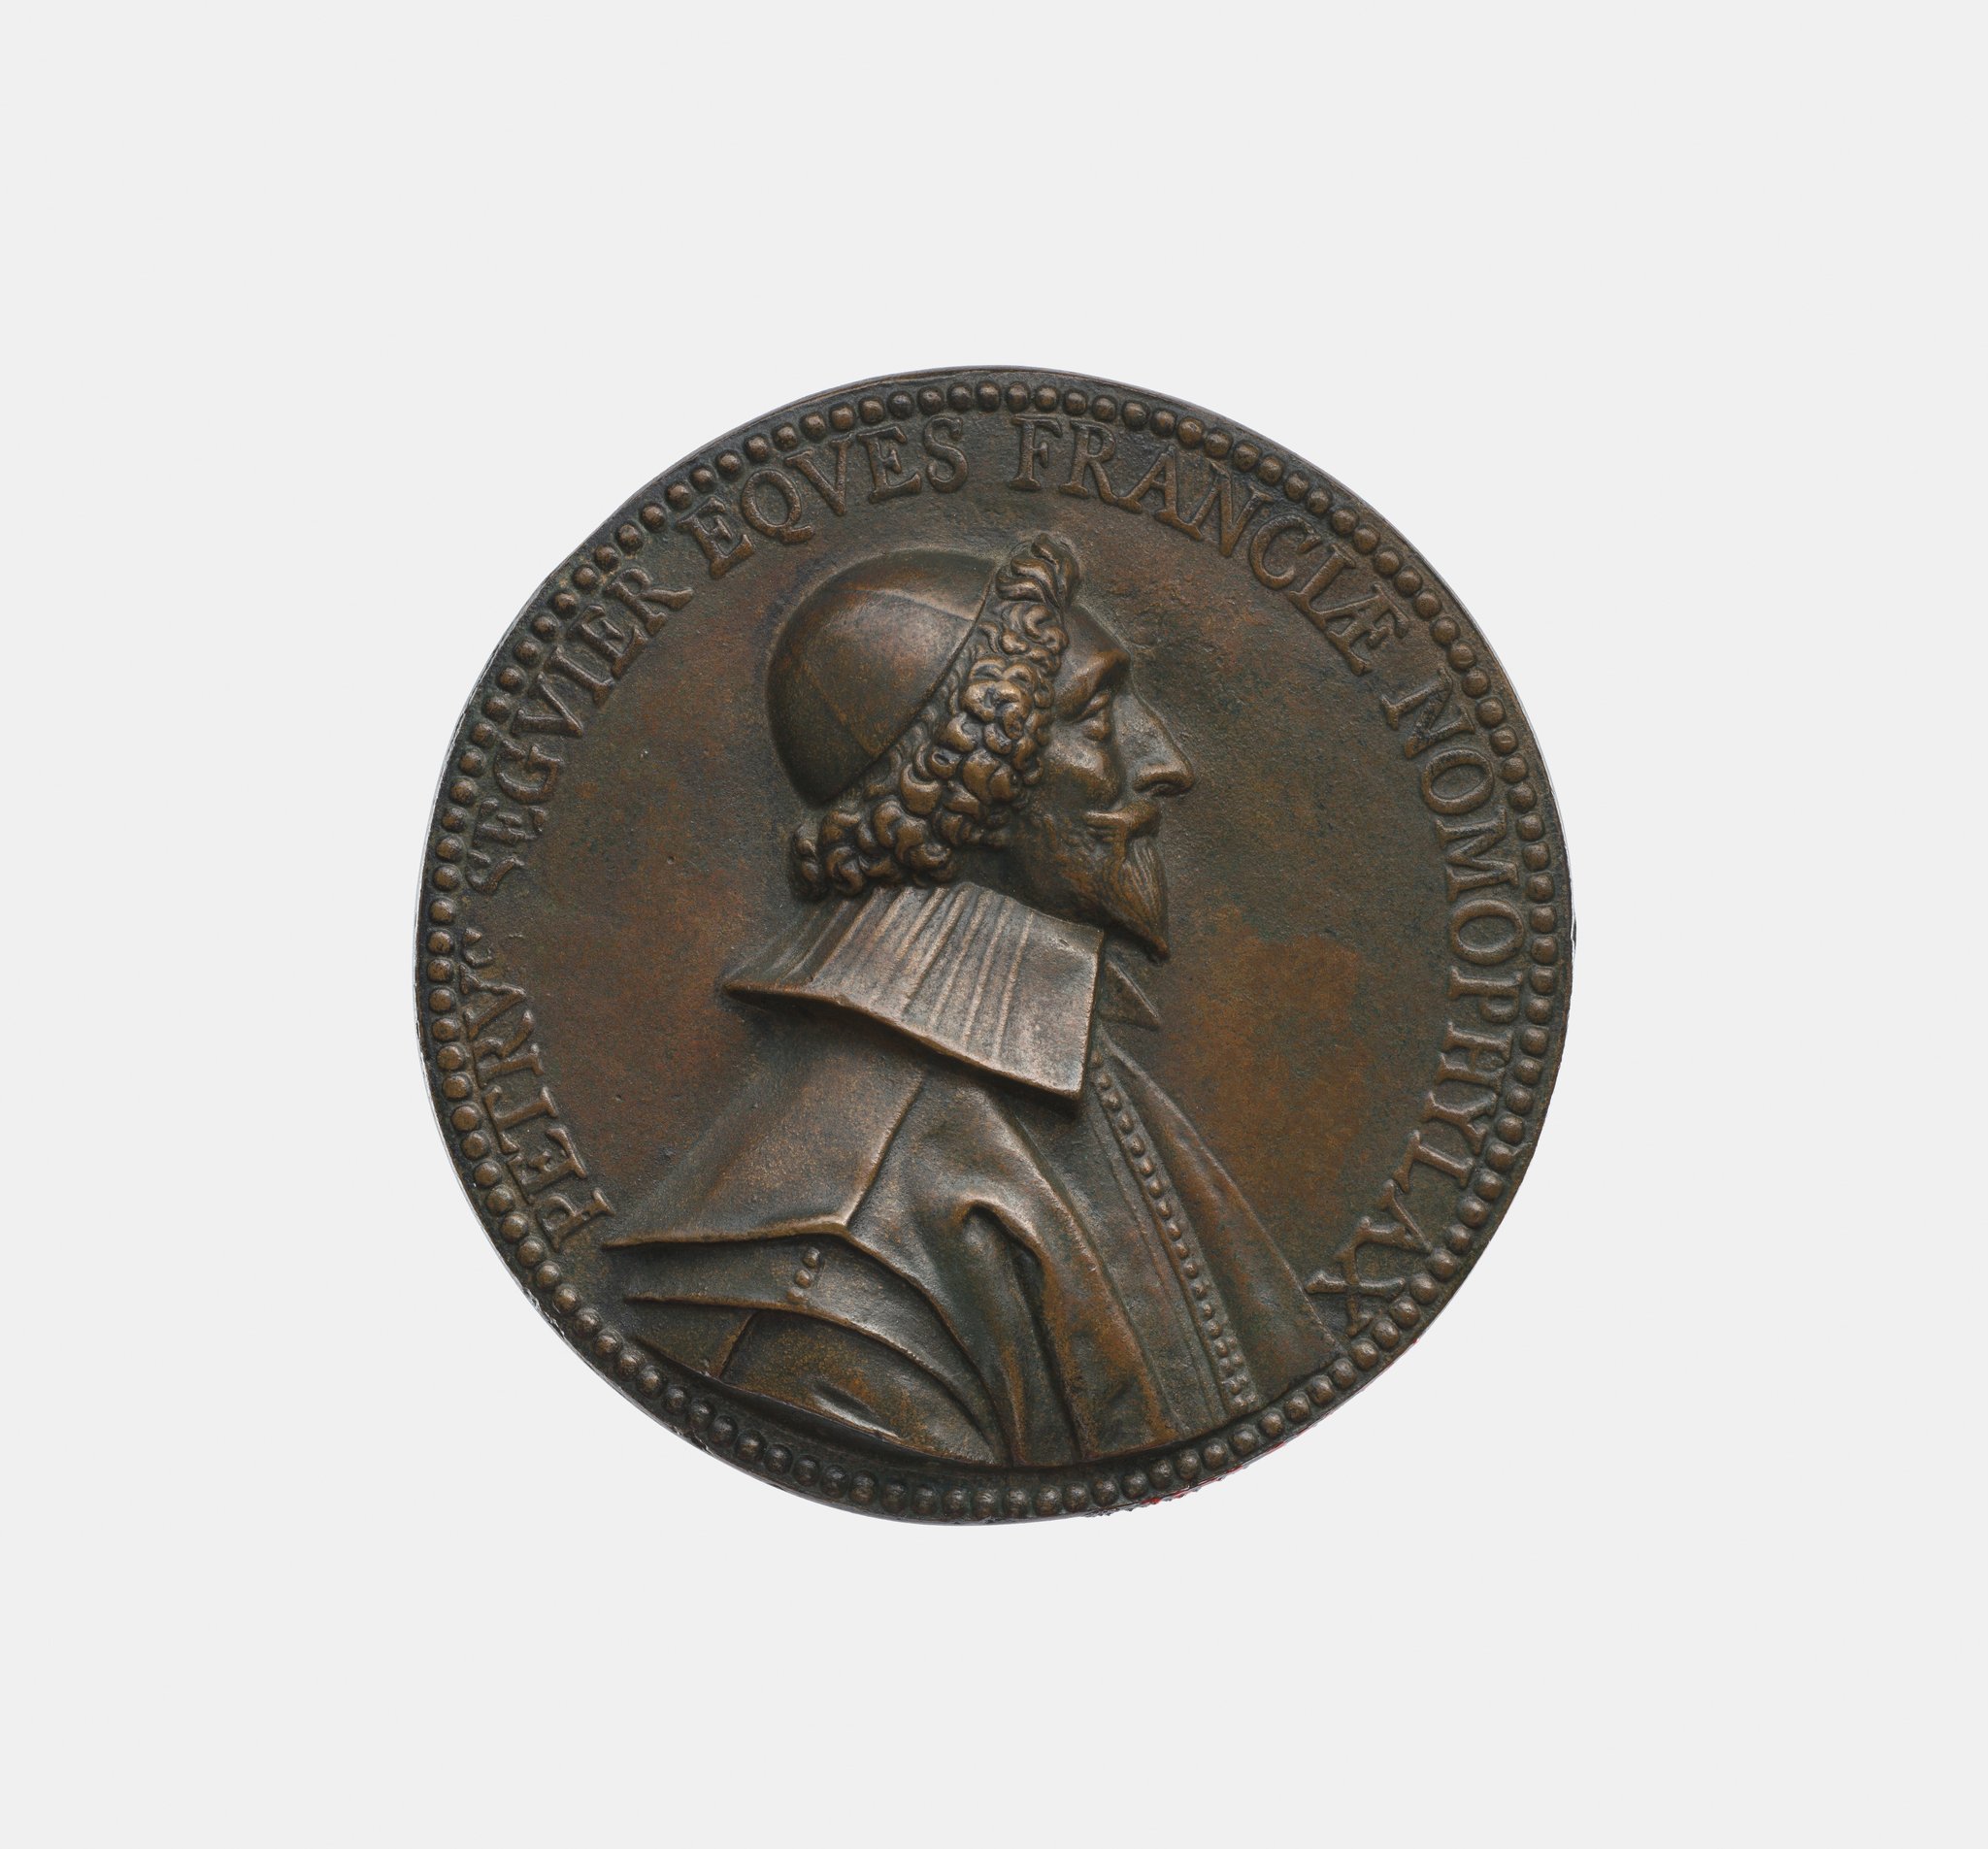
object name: medal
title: Petrus (Pierre) Séguier, Keeper of Seals and Chancellor of France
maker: claude varin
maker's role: artist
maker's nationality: french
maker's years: 1630-1654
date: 1633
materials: bronze